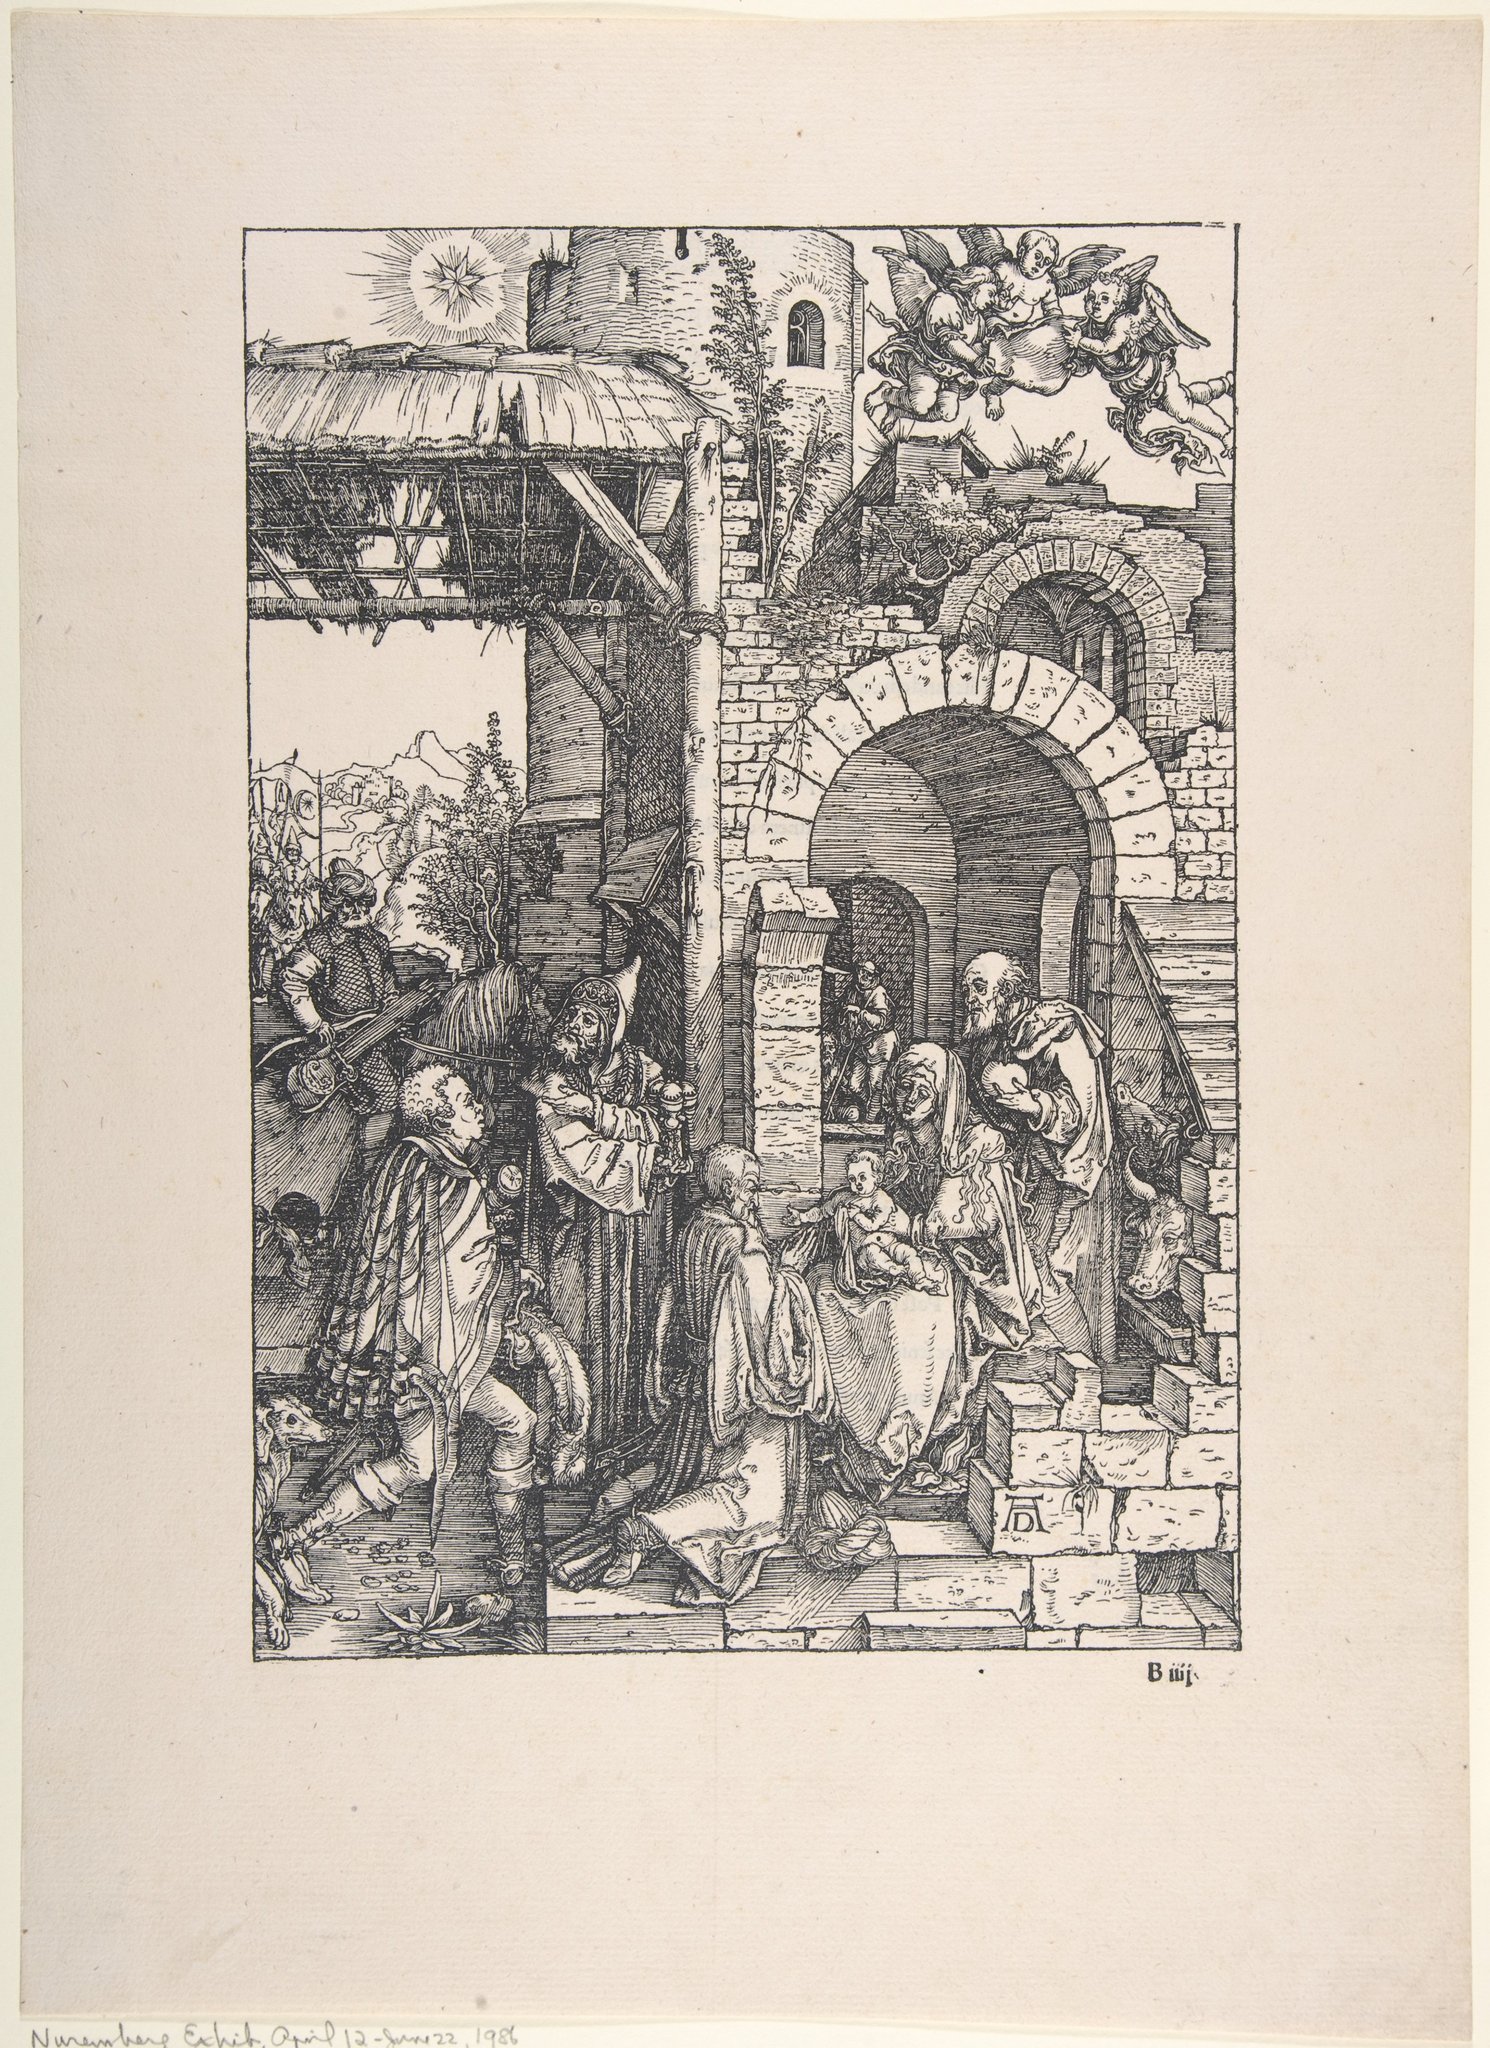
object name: print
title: The Adoration of the Magi, from "The Life of the Virgin"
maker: albrecht dürer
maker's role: artist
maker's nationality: german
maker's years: 1471-1528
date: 1502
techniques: woodcut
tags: angels,virgin mary,jesus,adoration of the magi